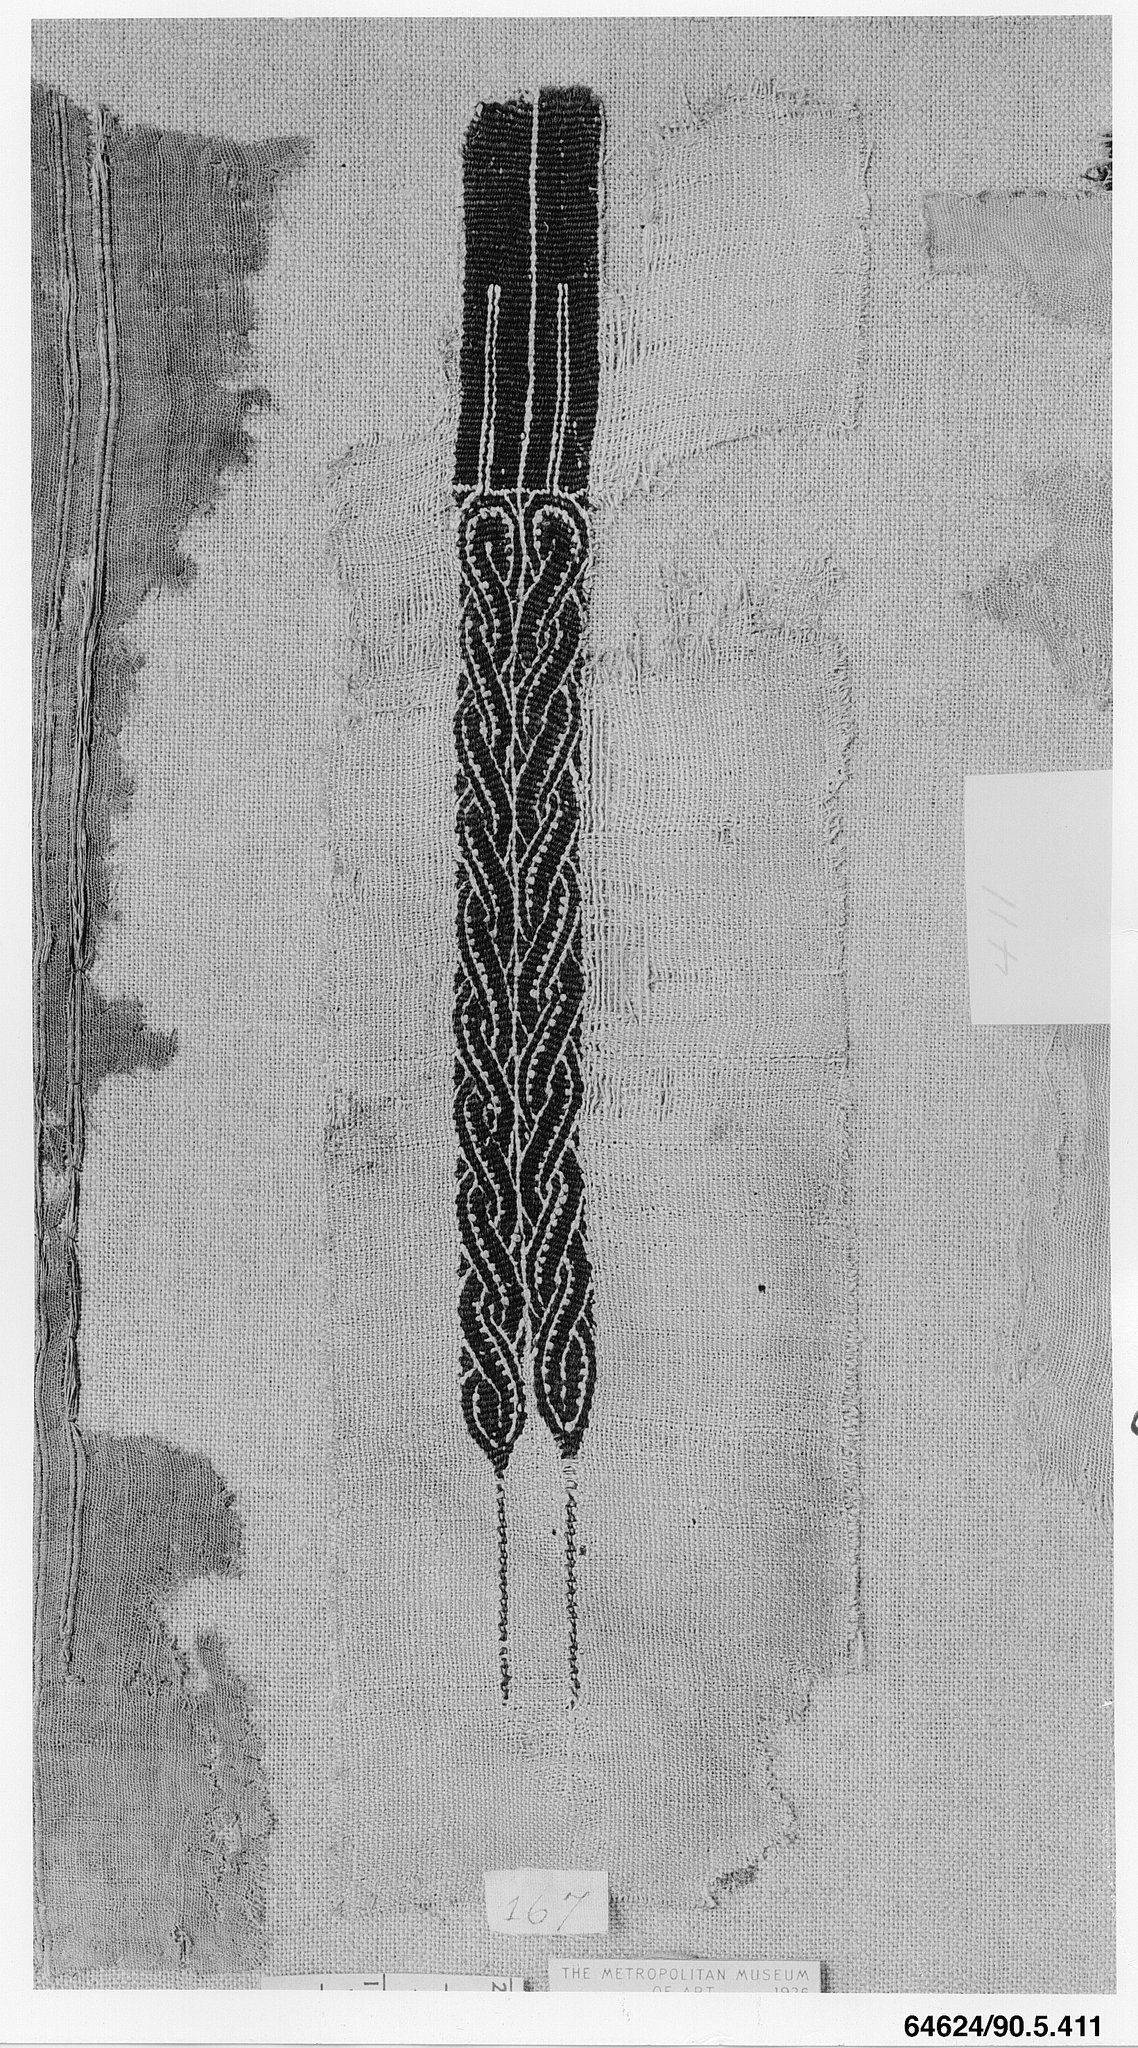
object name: textile fragment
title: Fragment of Shoulder Band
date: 201-400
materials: linen, wool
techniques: weave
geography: egypt